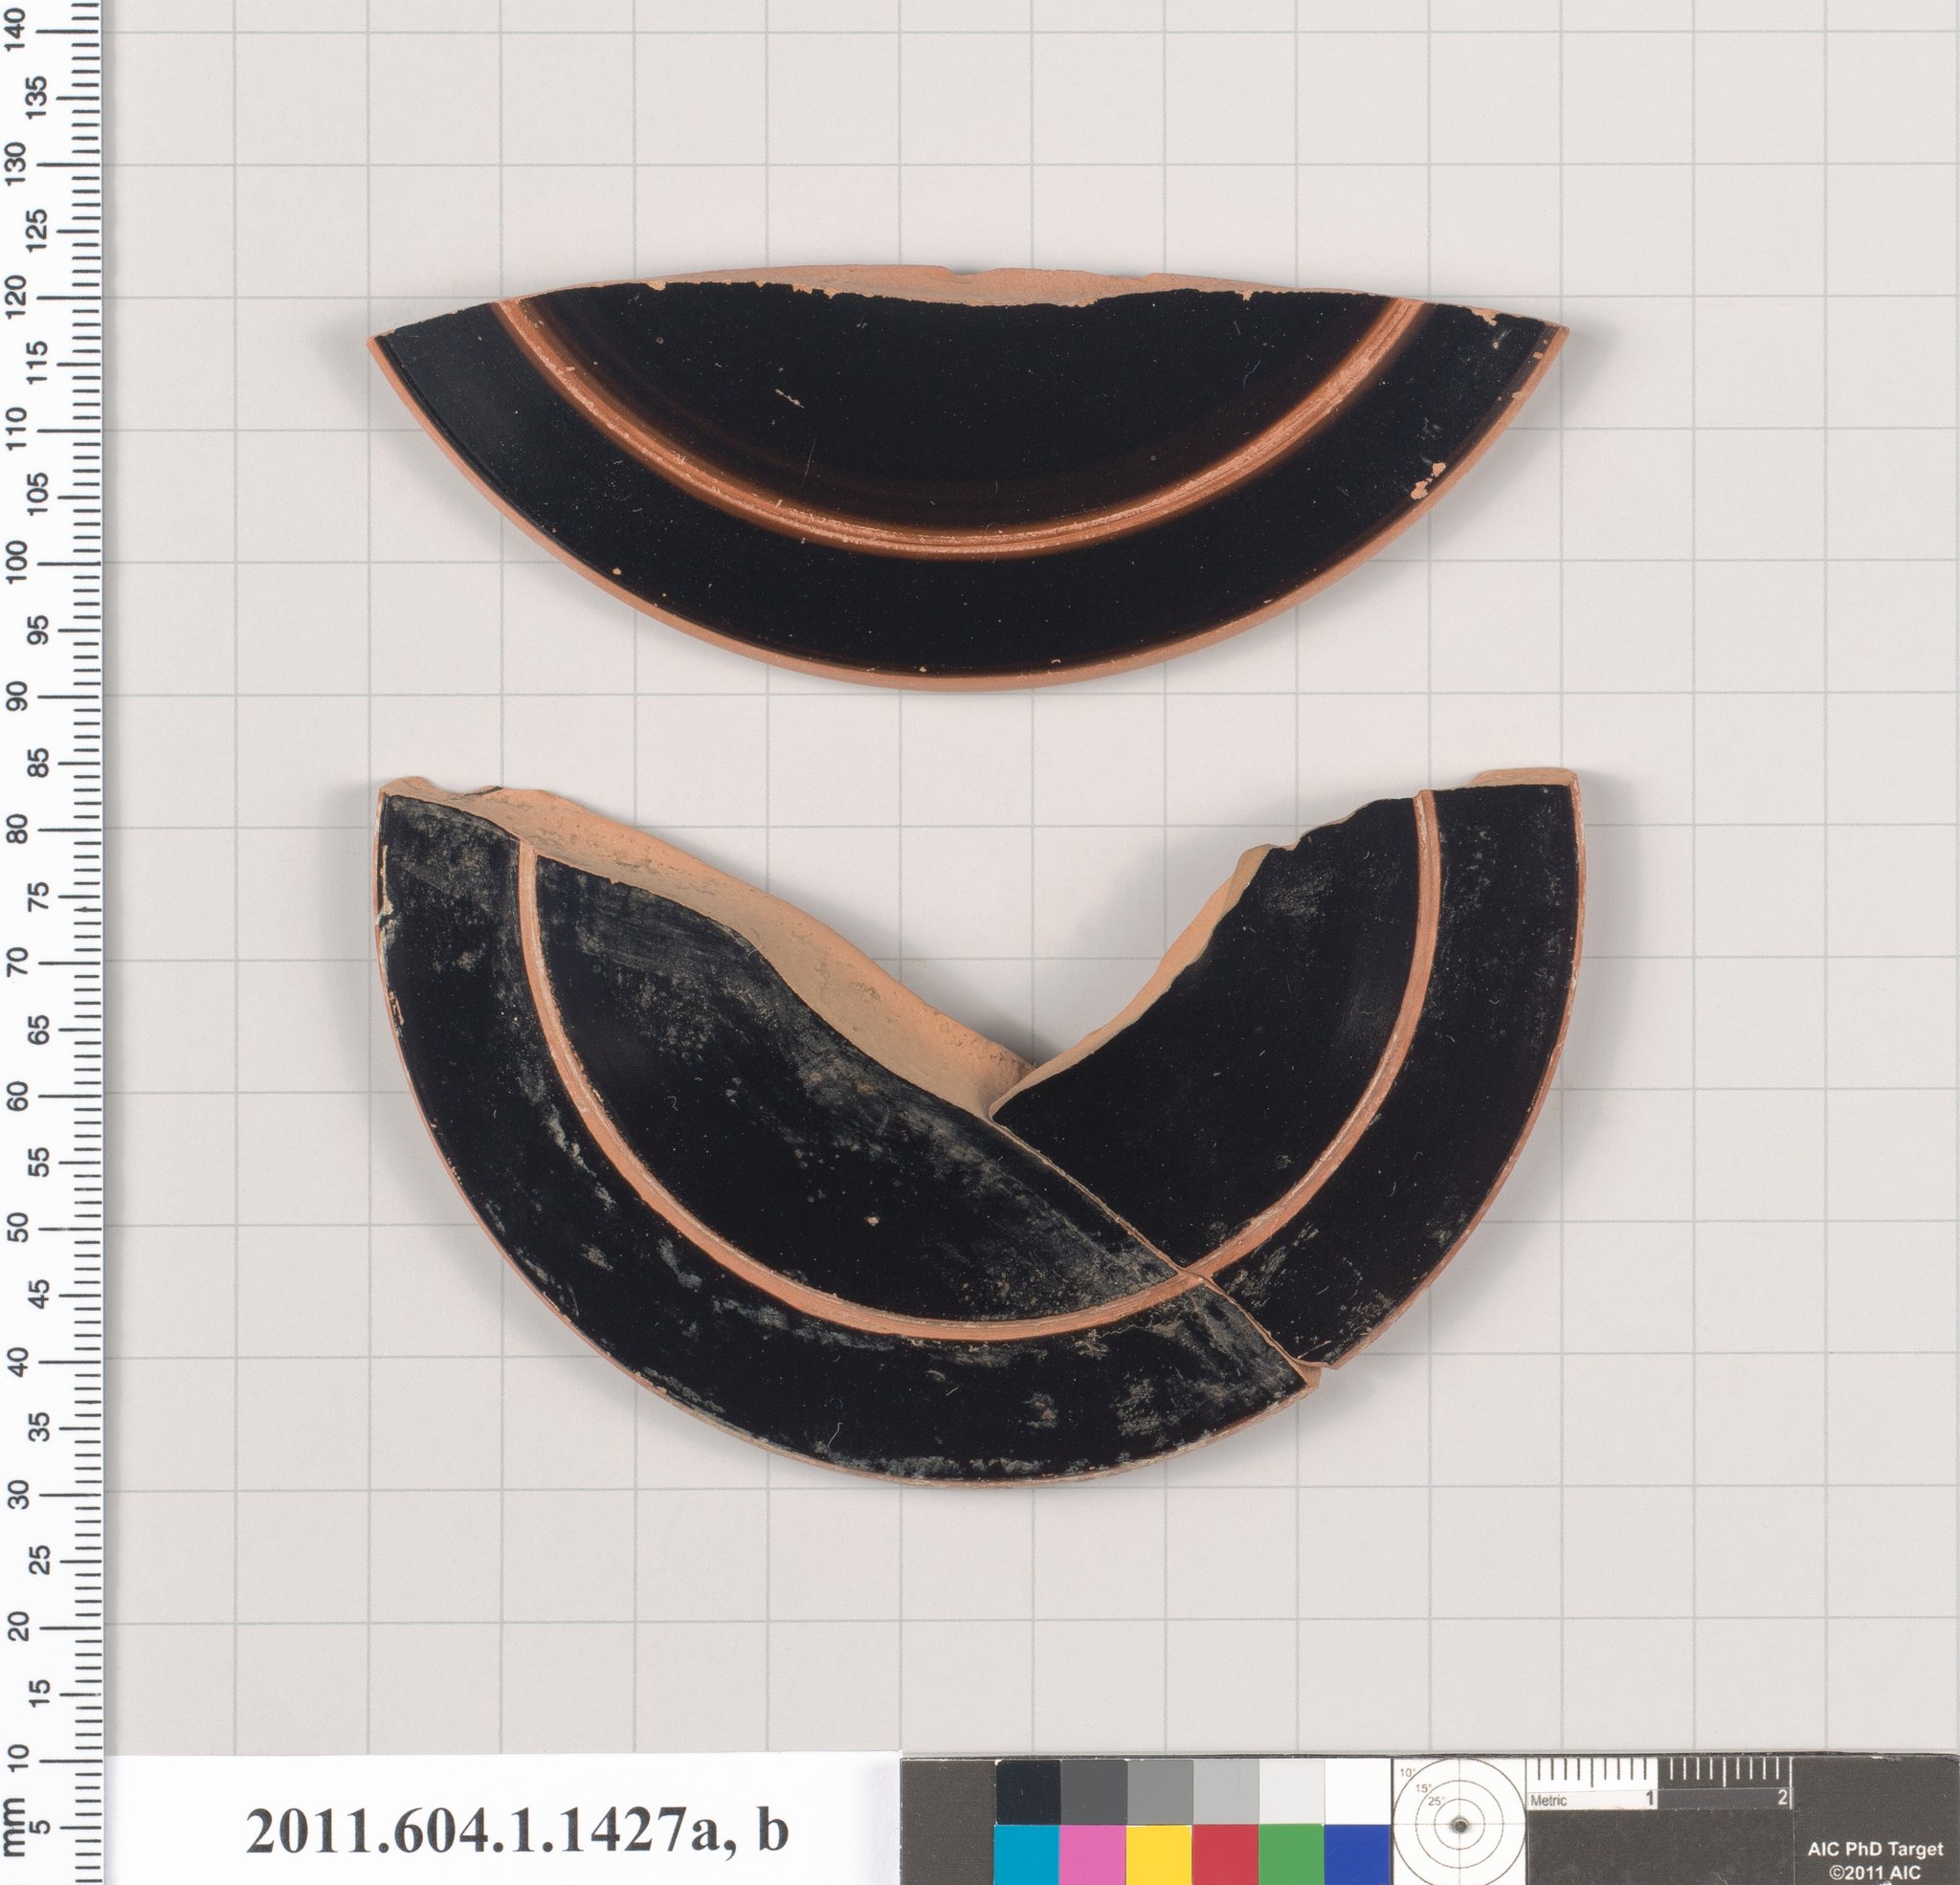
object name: kylix fragment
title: Terracotta fragments of kylikes (drinking cups)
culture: greek, attic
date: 500-401 BCE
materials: terracotta